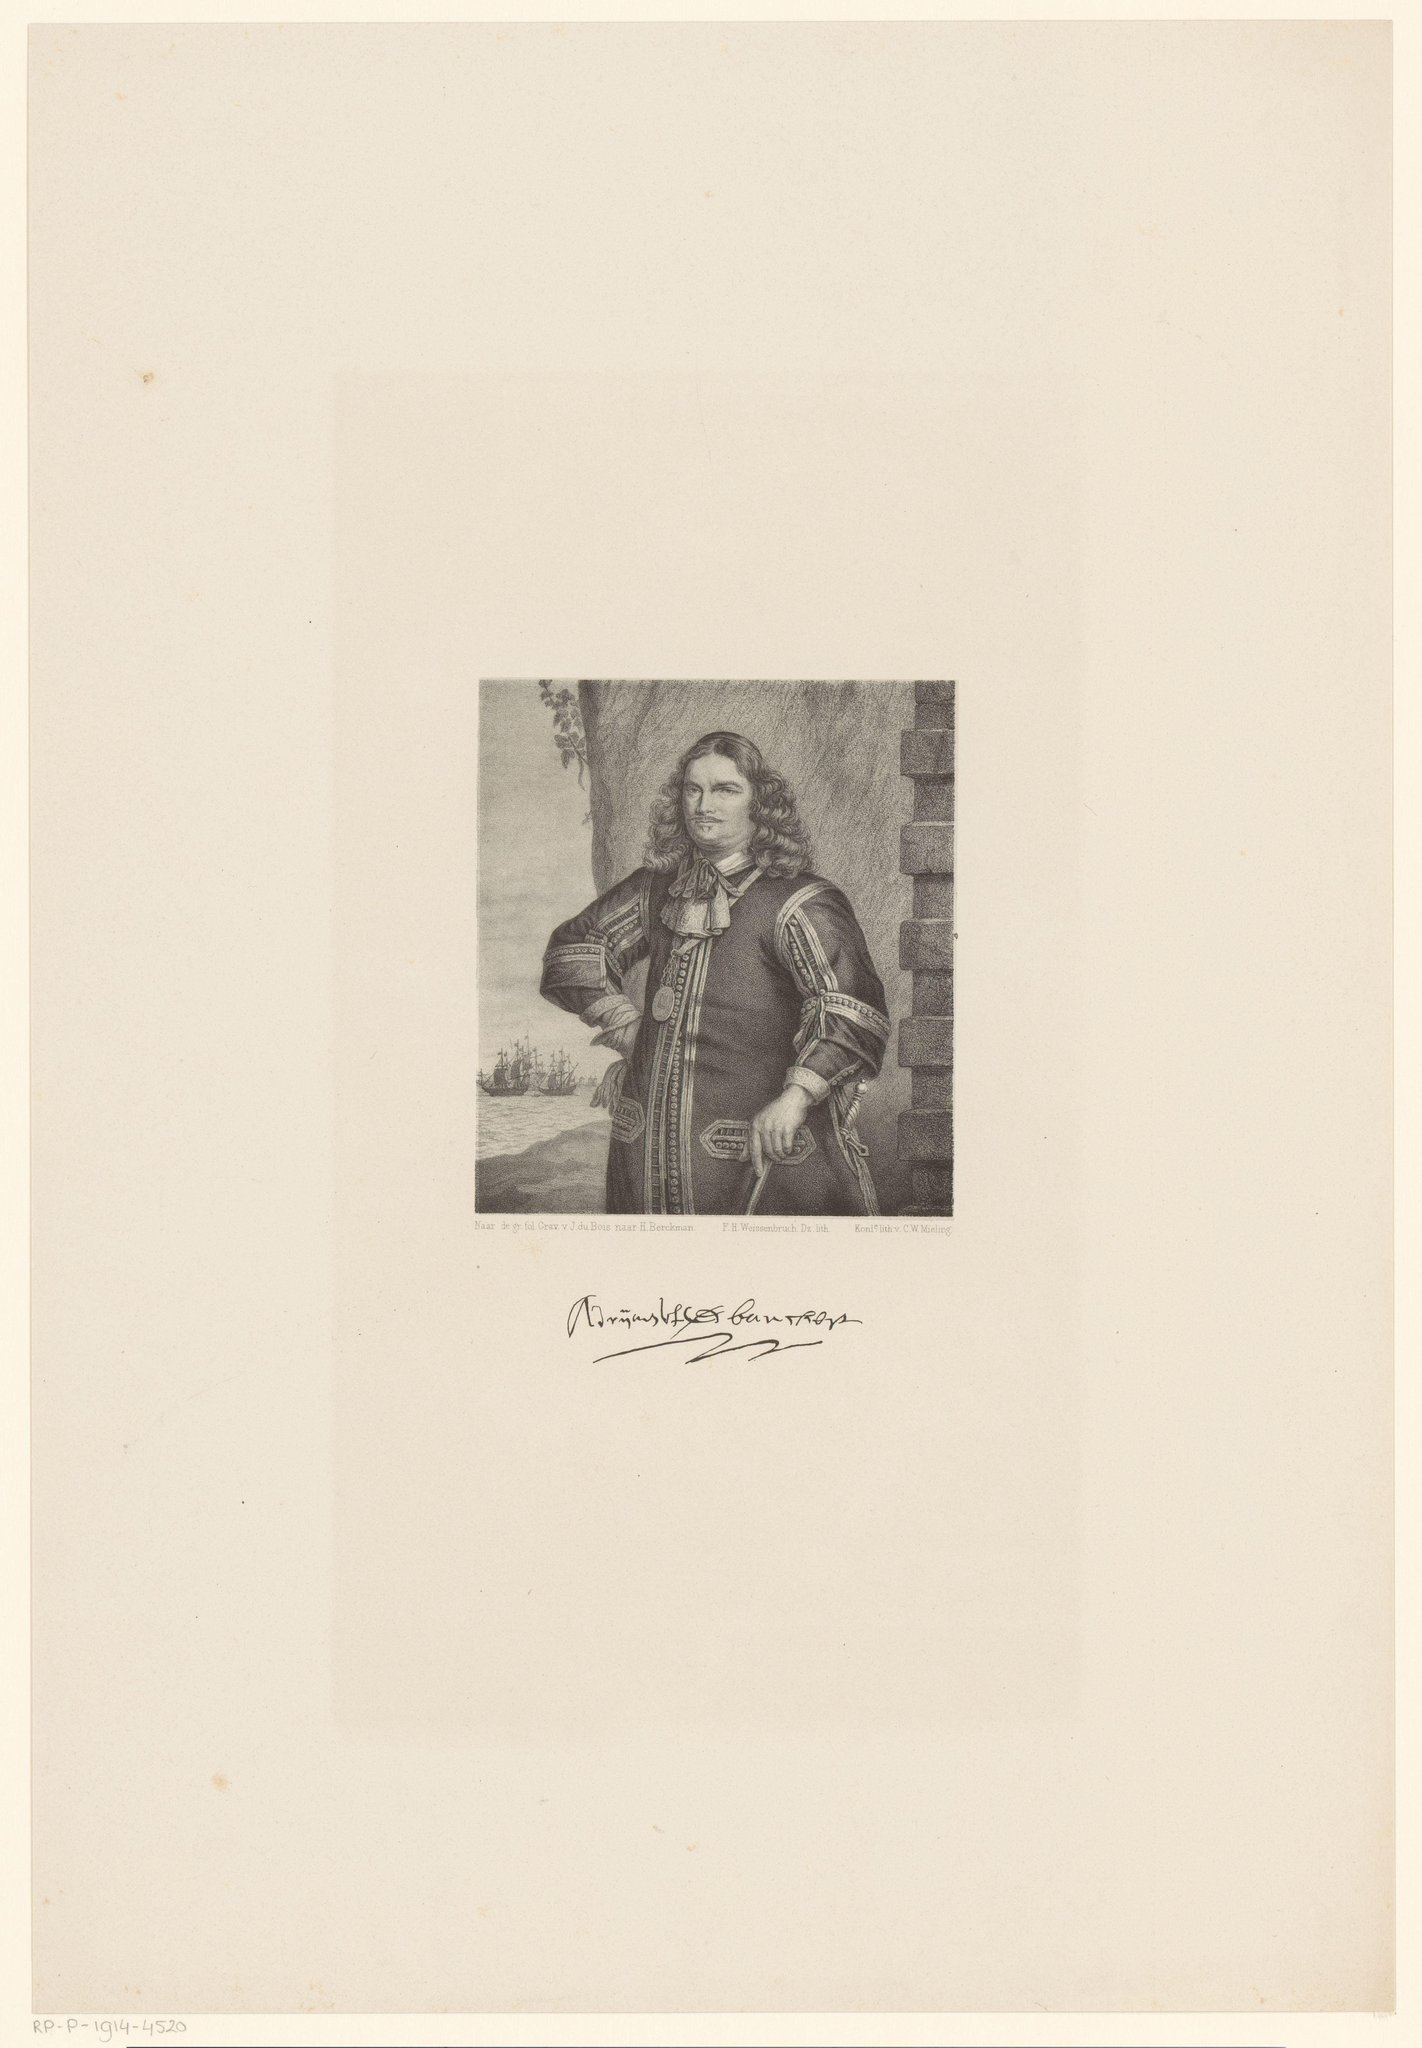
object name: print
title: Portret van Adriaen Banckert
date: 1858-1862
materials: paper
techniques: lithograph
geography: the hague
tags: middelburg, historical persons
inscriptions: collector's mark: Lugt 2228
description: Prent uit: Jonge, J.C. de. Geschiedenis van het Nederlandsche zeewezen. Haarlem: Jonge, J.K.J. de, 1858-62.